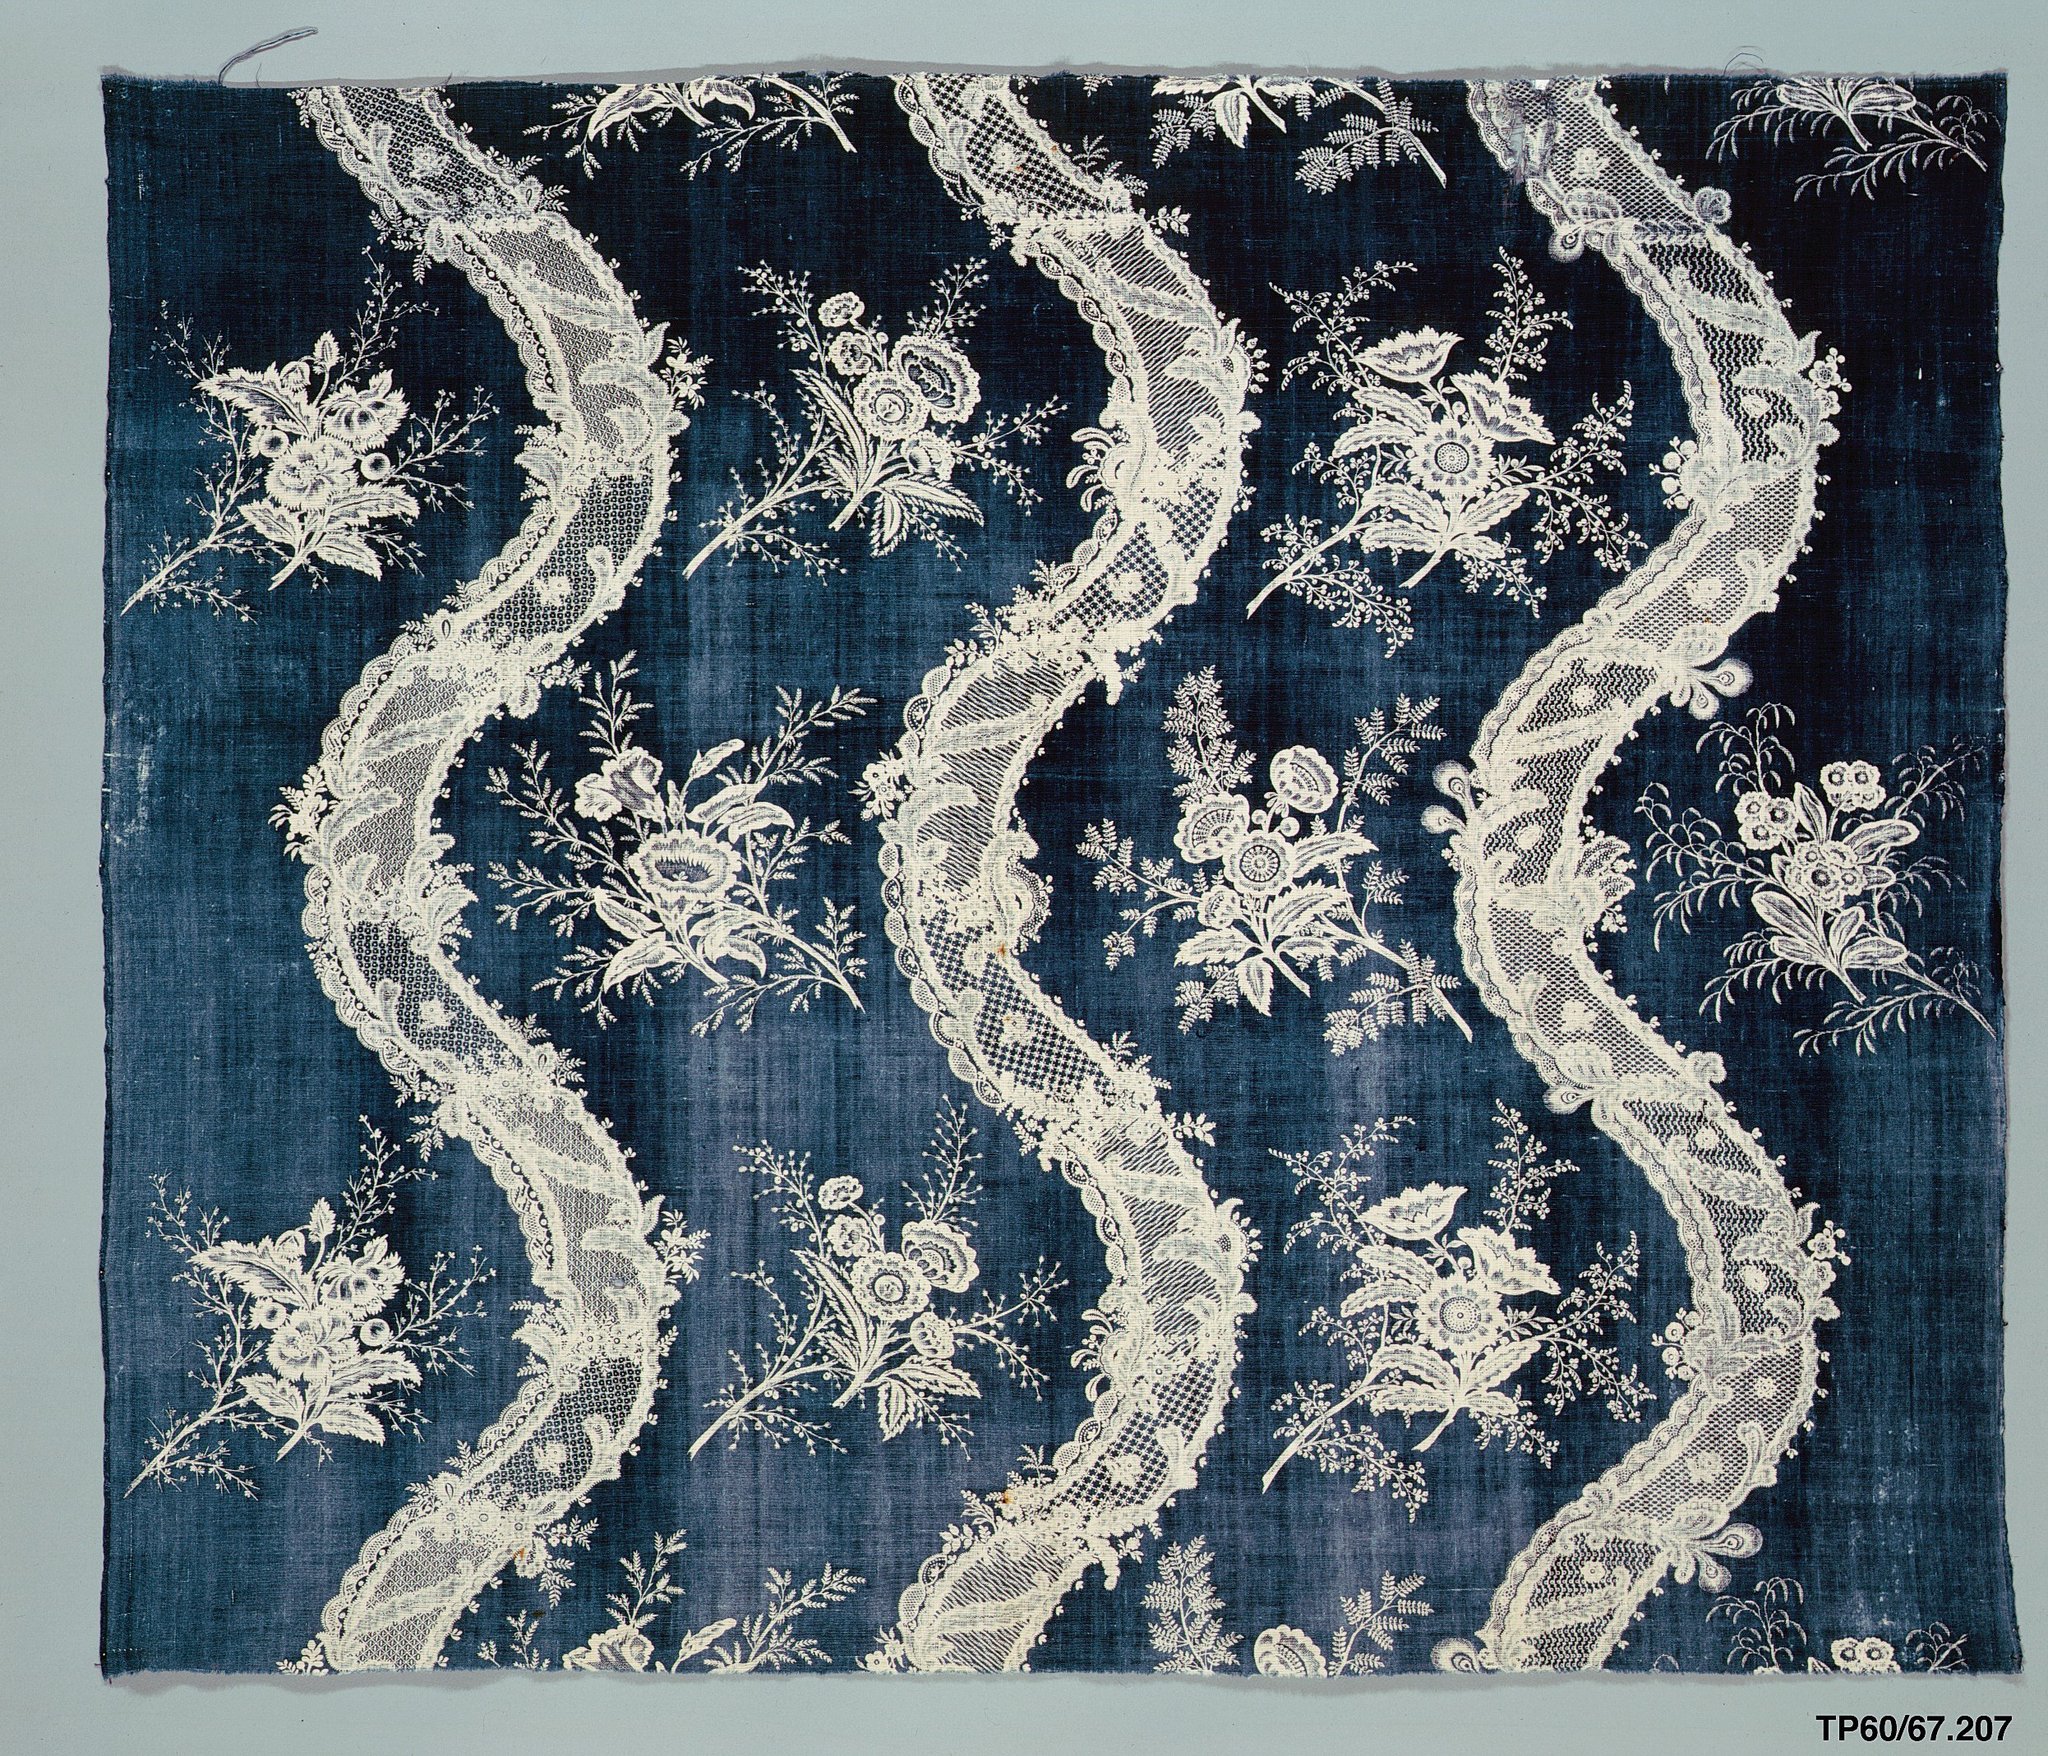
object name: piece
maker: bromley hall printworks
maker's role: manufactory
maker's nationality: english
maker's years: 1694-1823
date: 1701-1800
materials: cotton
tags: flowers,leaves